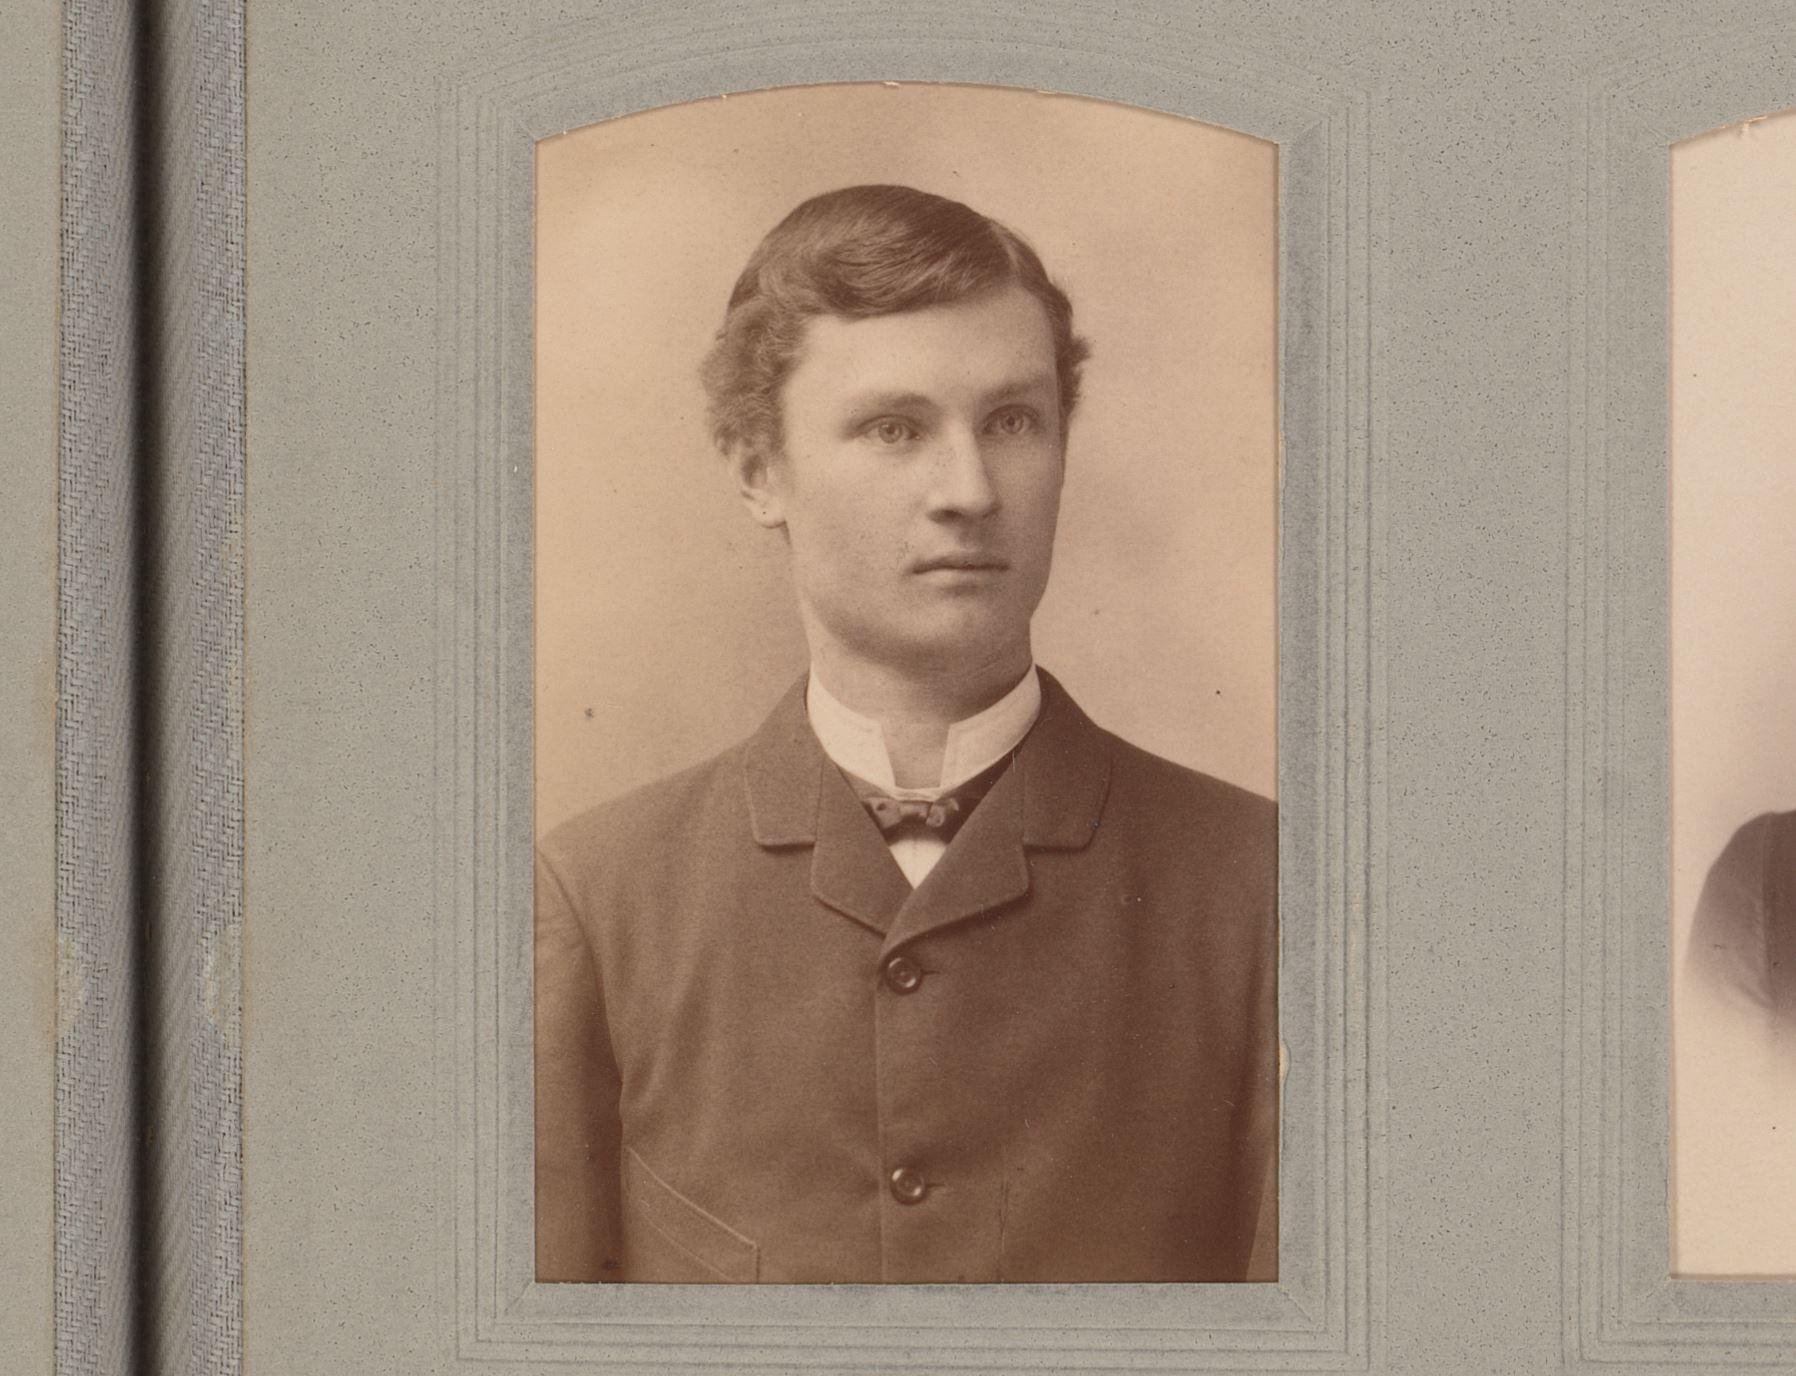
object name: photograph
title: Portret van een jonge man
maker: peter ludvig quist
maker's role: fotograaf, hoffotograaf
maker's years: 1833-1924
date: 1885-1900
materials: cardboard, photographic support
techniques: albumen print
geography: stockholm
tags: historical persons, youth, adolescent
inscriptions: inscription: ‘ATELIER för FOTOGRAFI/ Regeringsgatan 59/ eller/ Jacobsbergsgatan 23./ LQ/ STOCKHOLM/ DUBLIN/ 1885/ PLÅTEN FÖRVARAS FÖR EFTERBESTÄLLNING.’